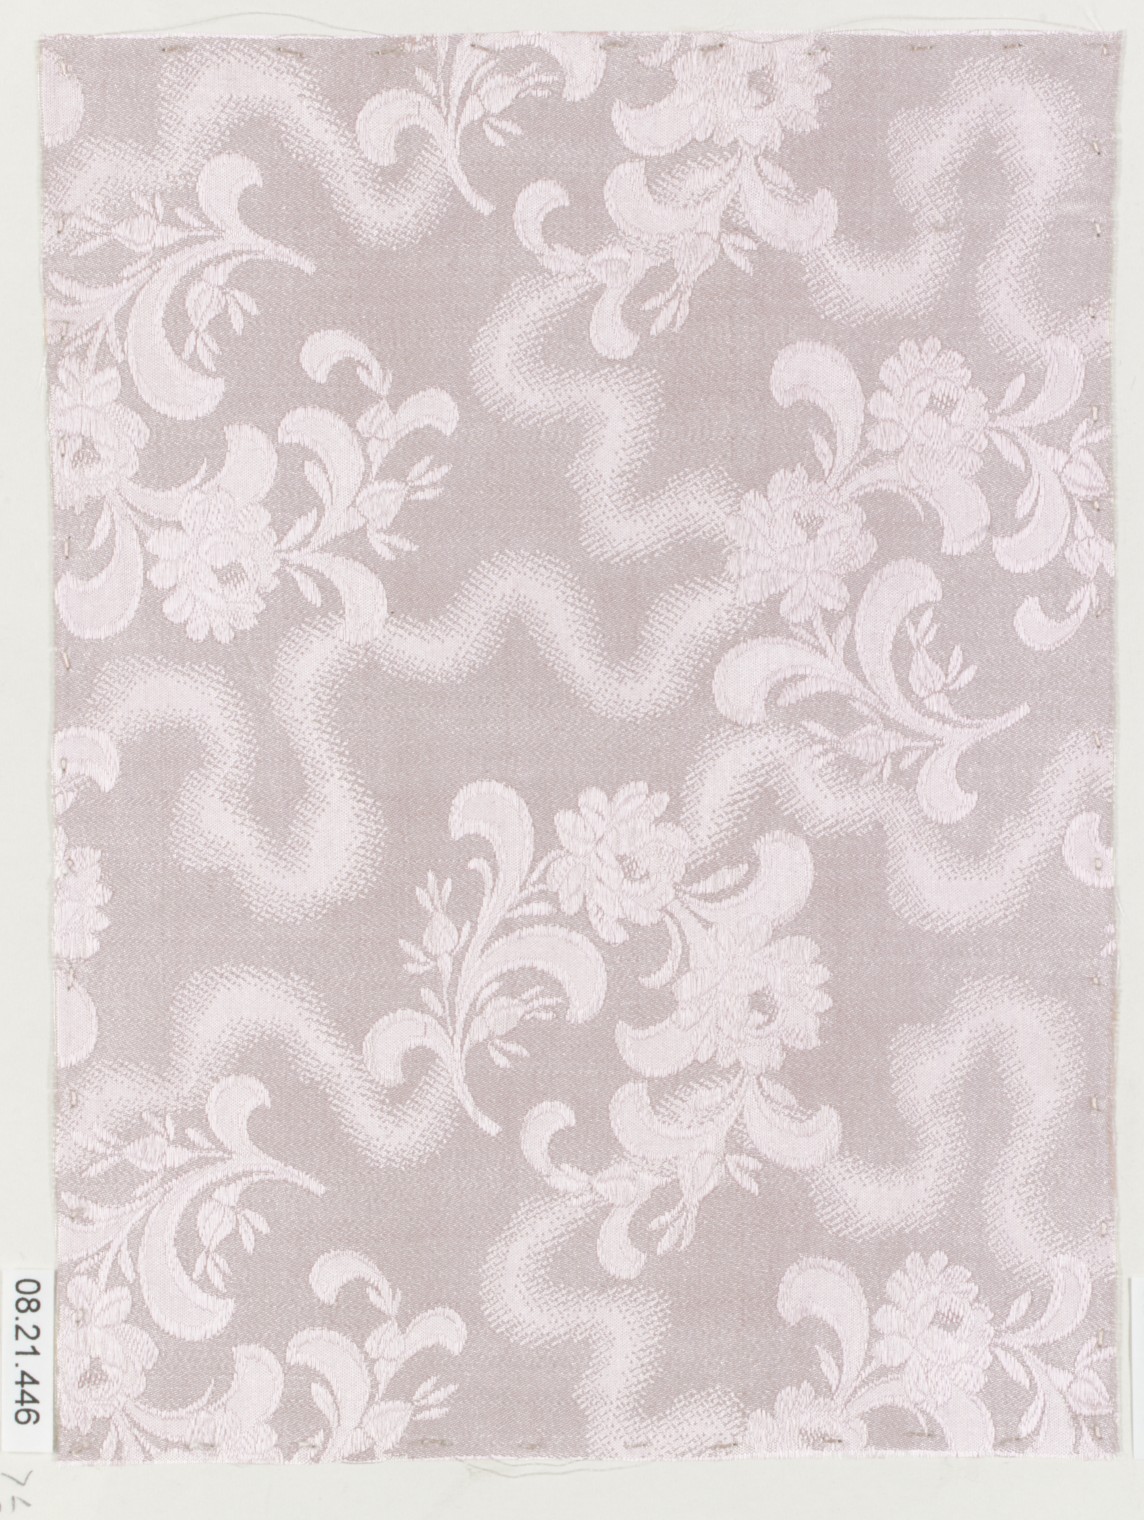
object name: textile sample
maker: Anonymous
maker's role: designer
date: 1900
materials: silk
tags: flowers